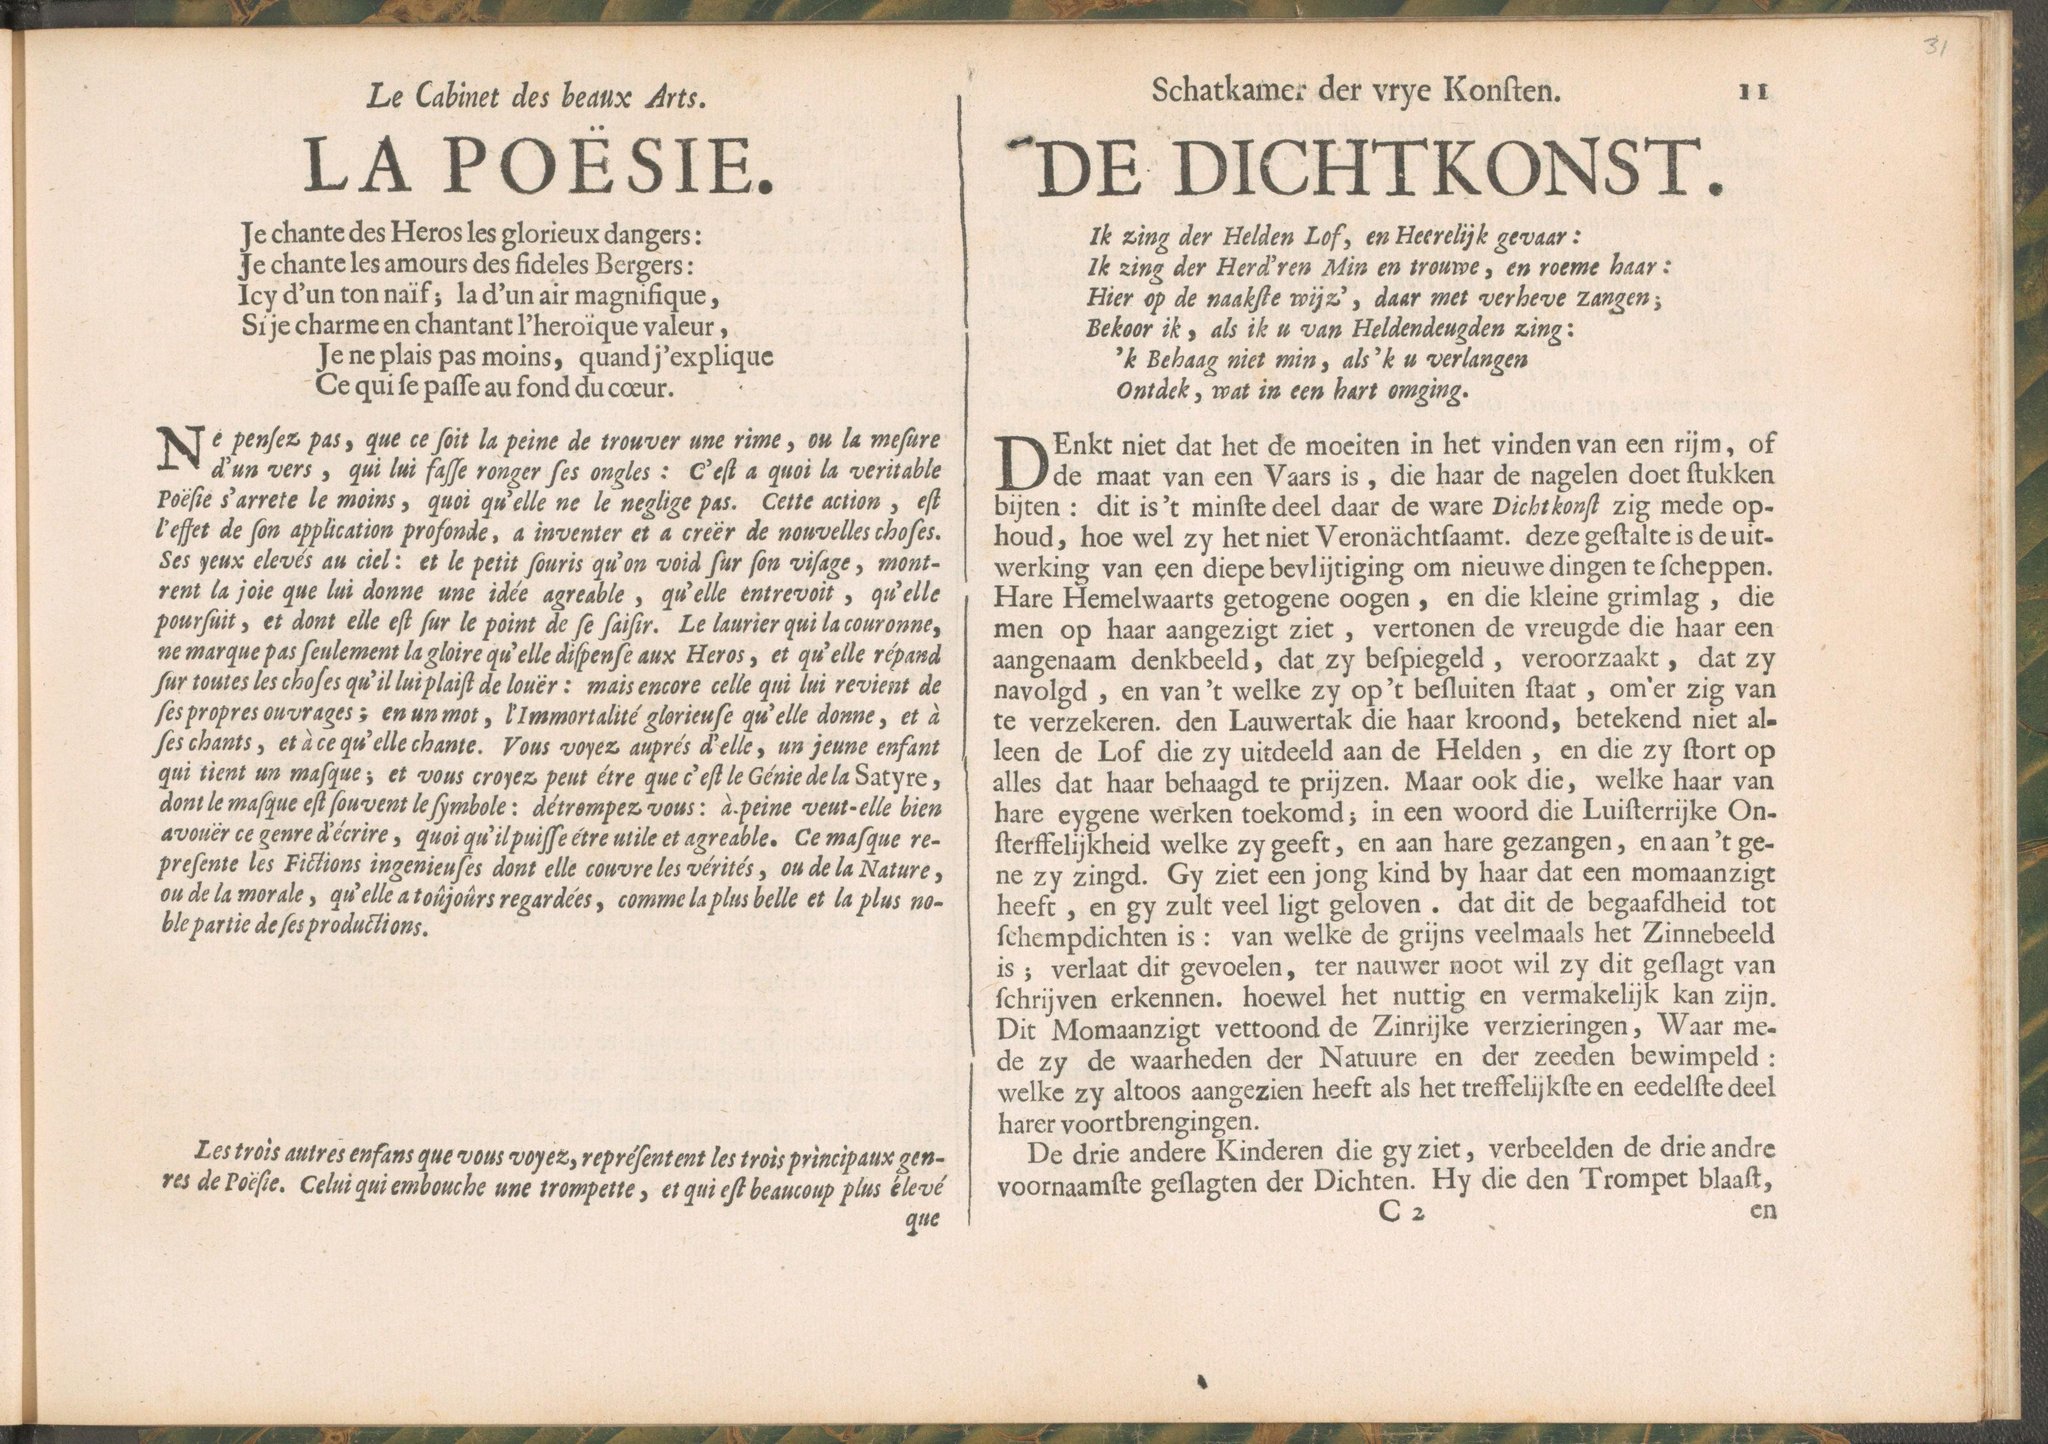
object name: text sheet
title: La Poësie / De Dichtkonst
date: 1693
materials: paper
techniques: letterpress printing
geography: amsterdam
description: Verklaring van de prent met de voorstelling van de personificatie van Dichtkunst in het Frans en het Nederlands, pagina 11. Tekstblad maakt deel uit van een album.